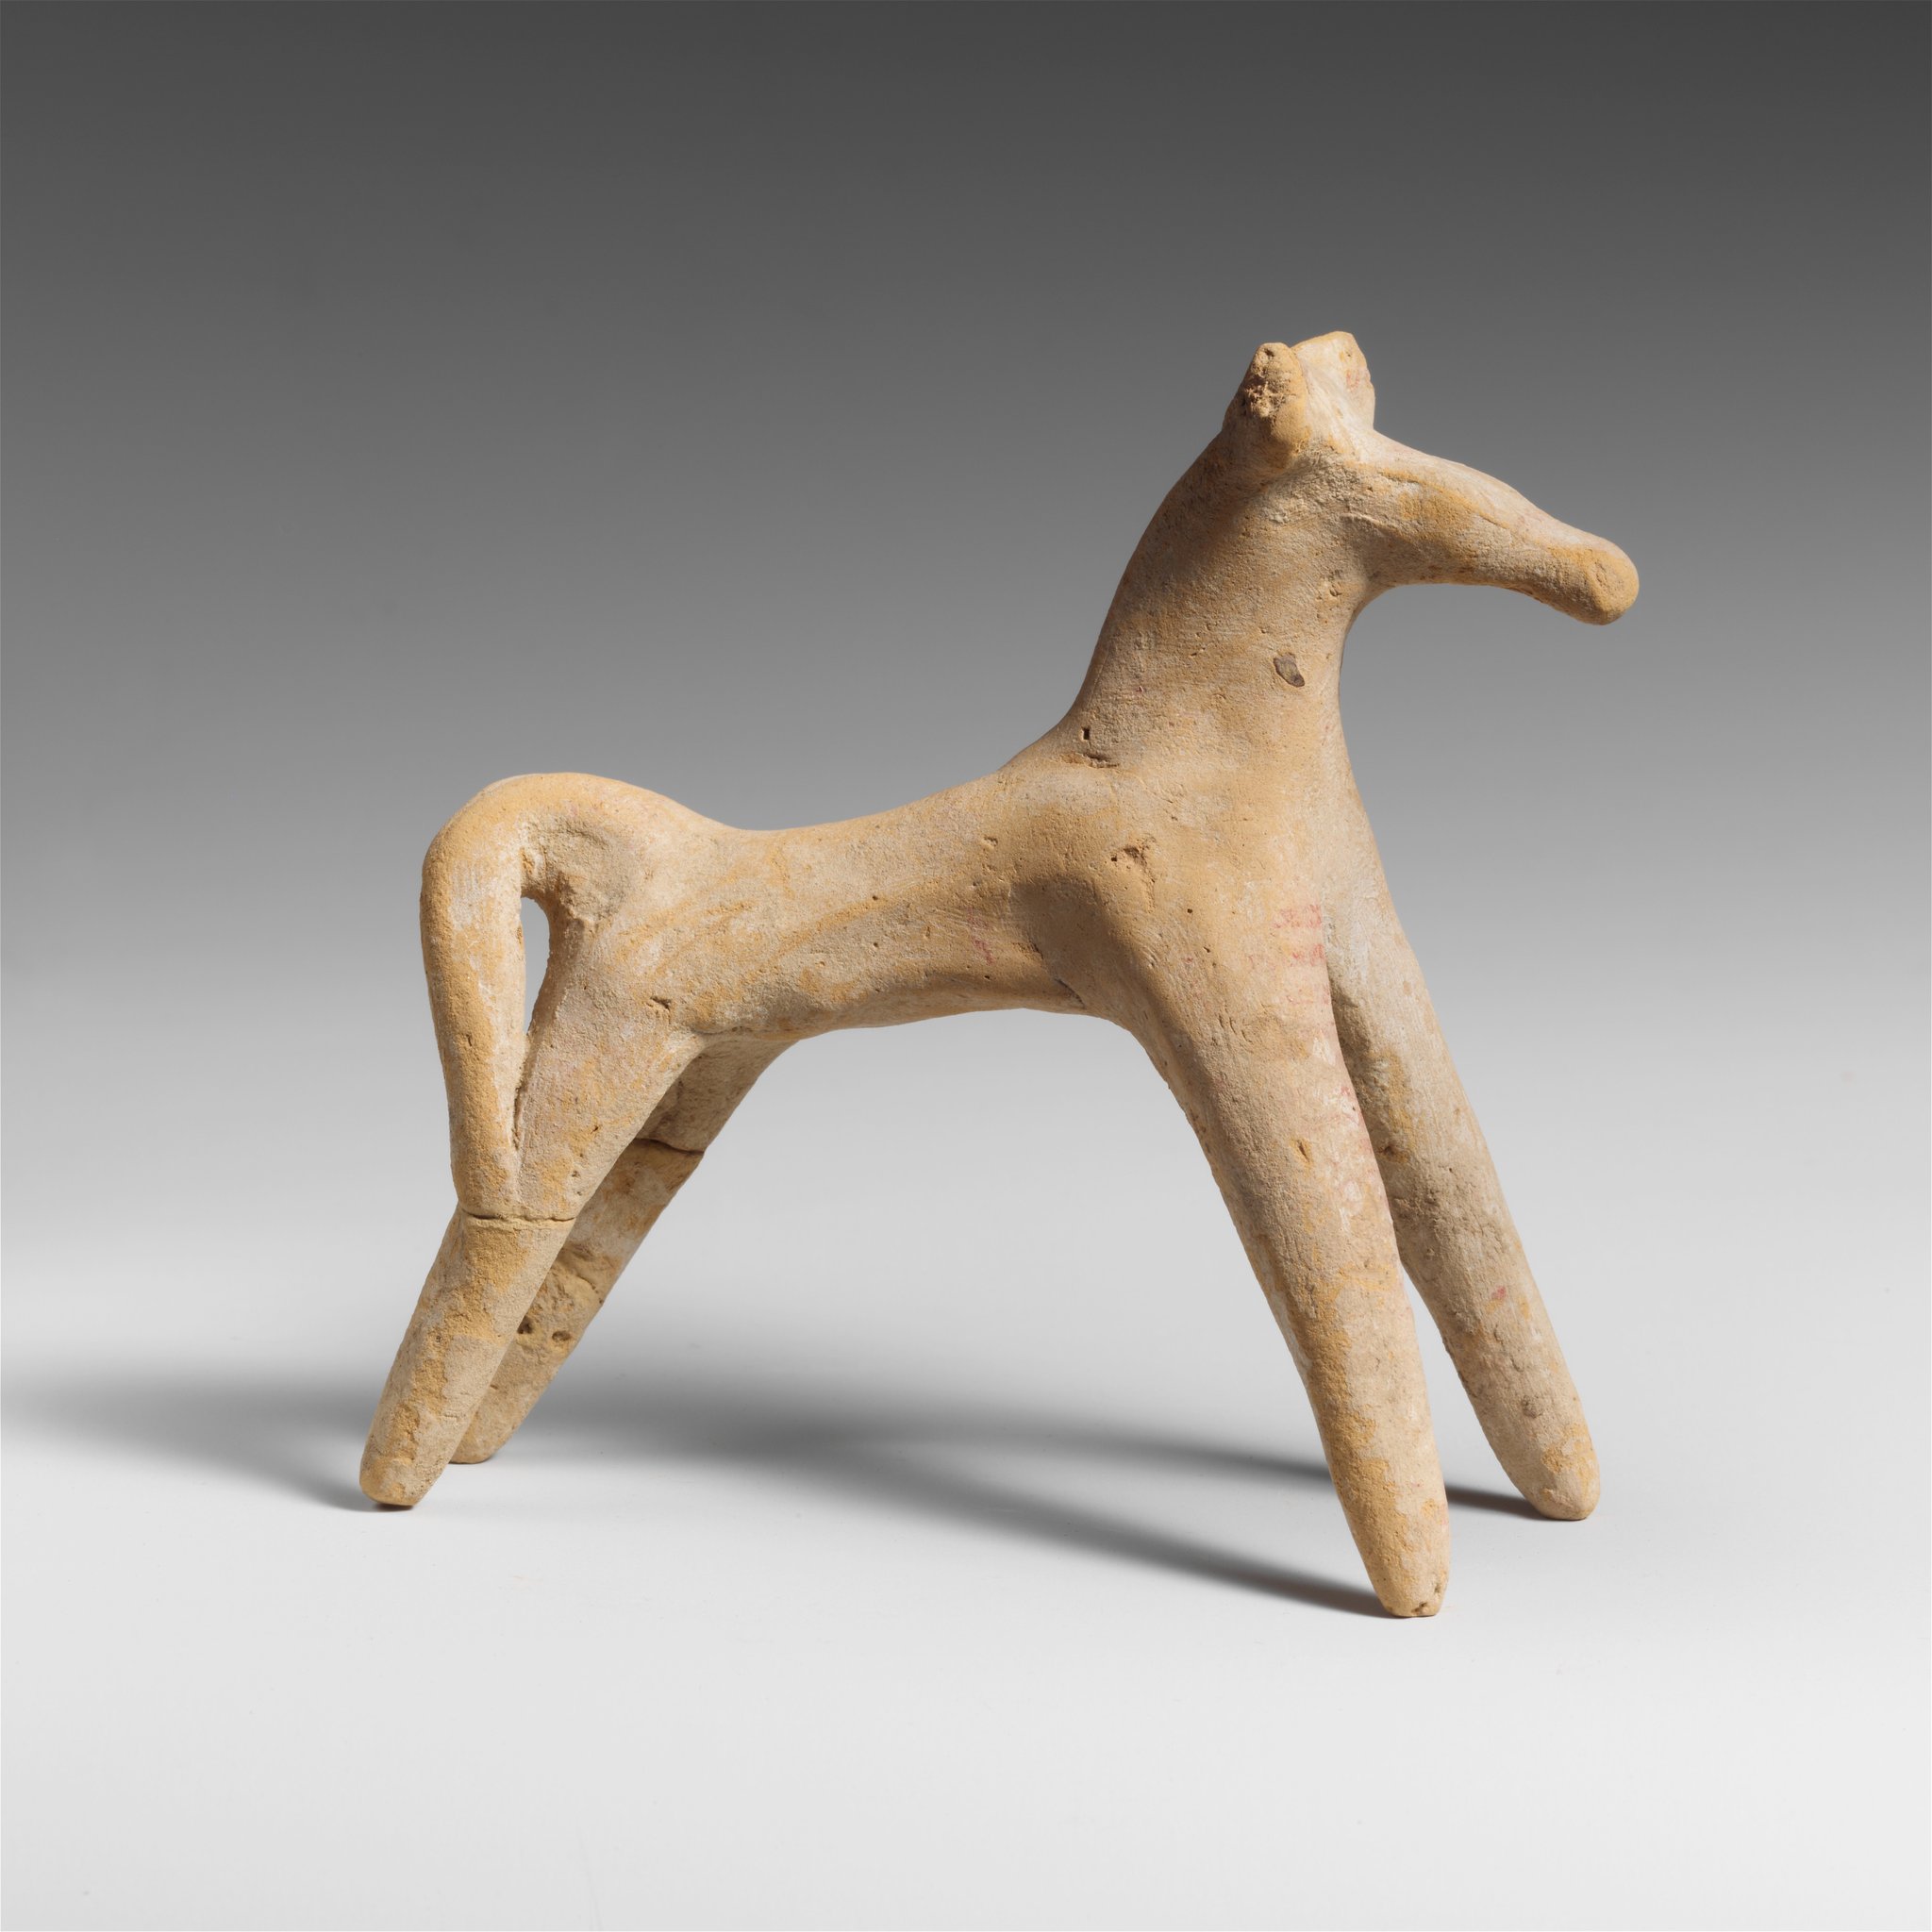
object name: statuette of a bull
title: Terracotta statuette of a bull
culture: greek, boeotian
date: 550-526 BCE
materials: terracotta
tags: bulls